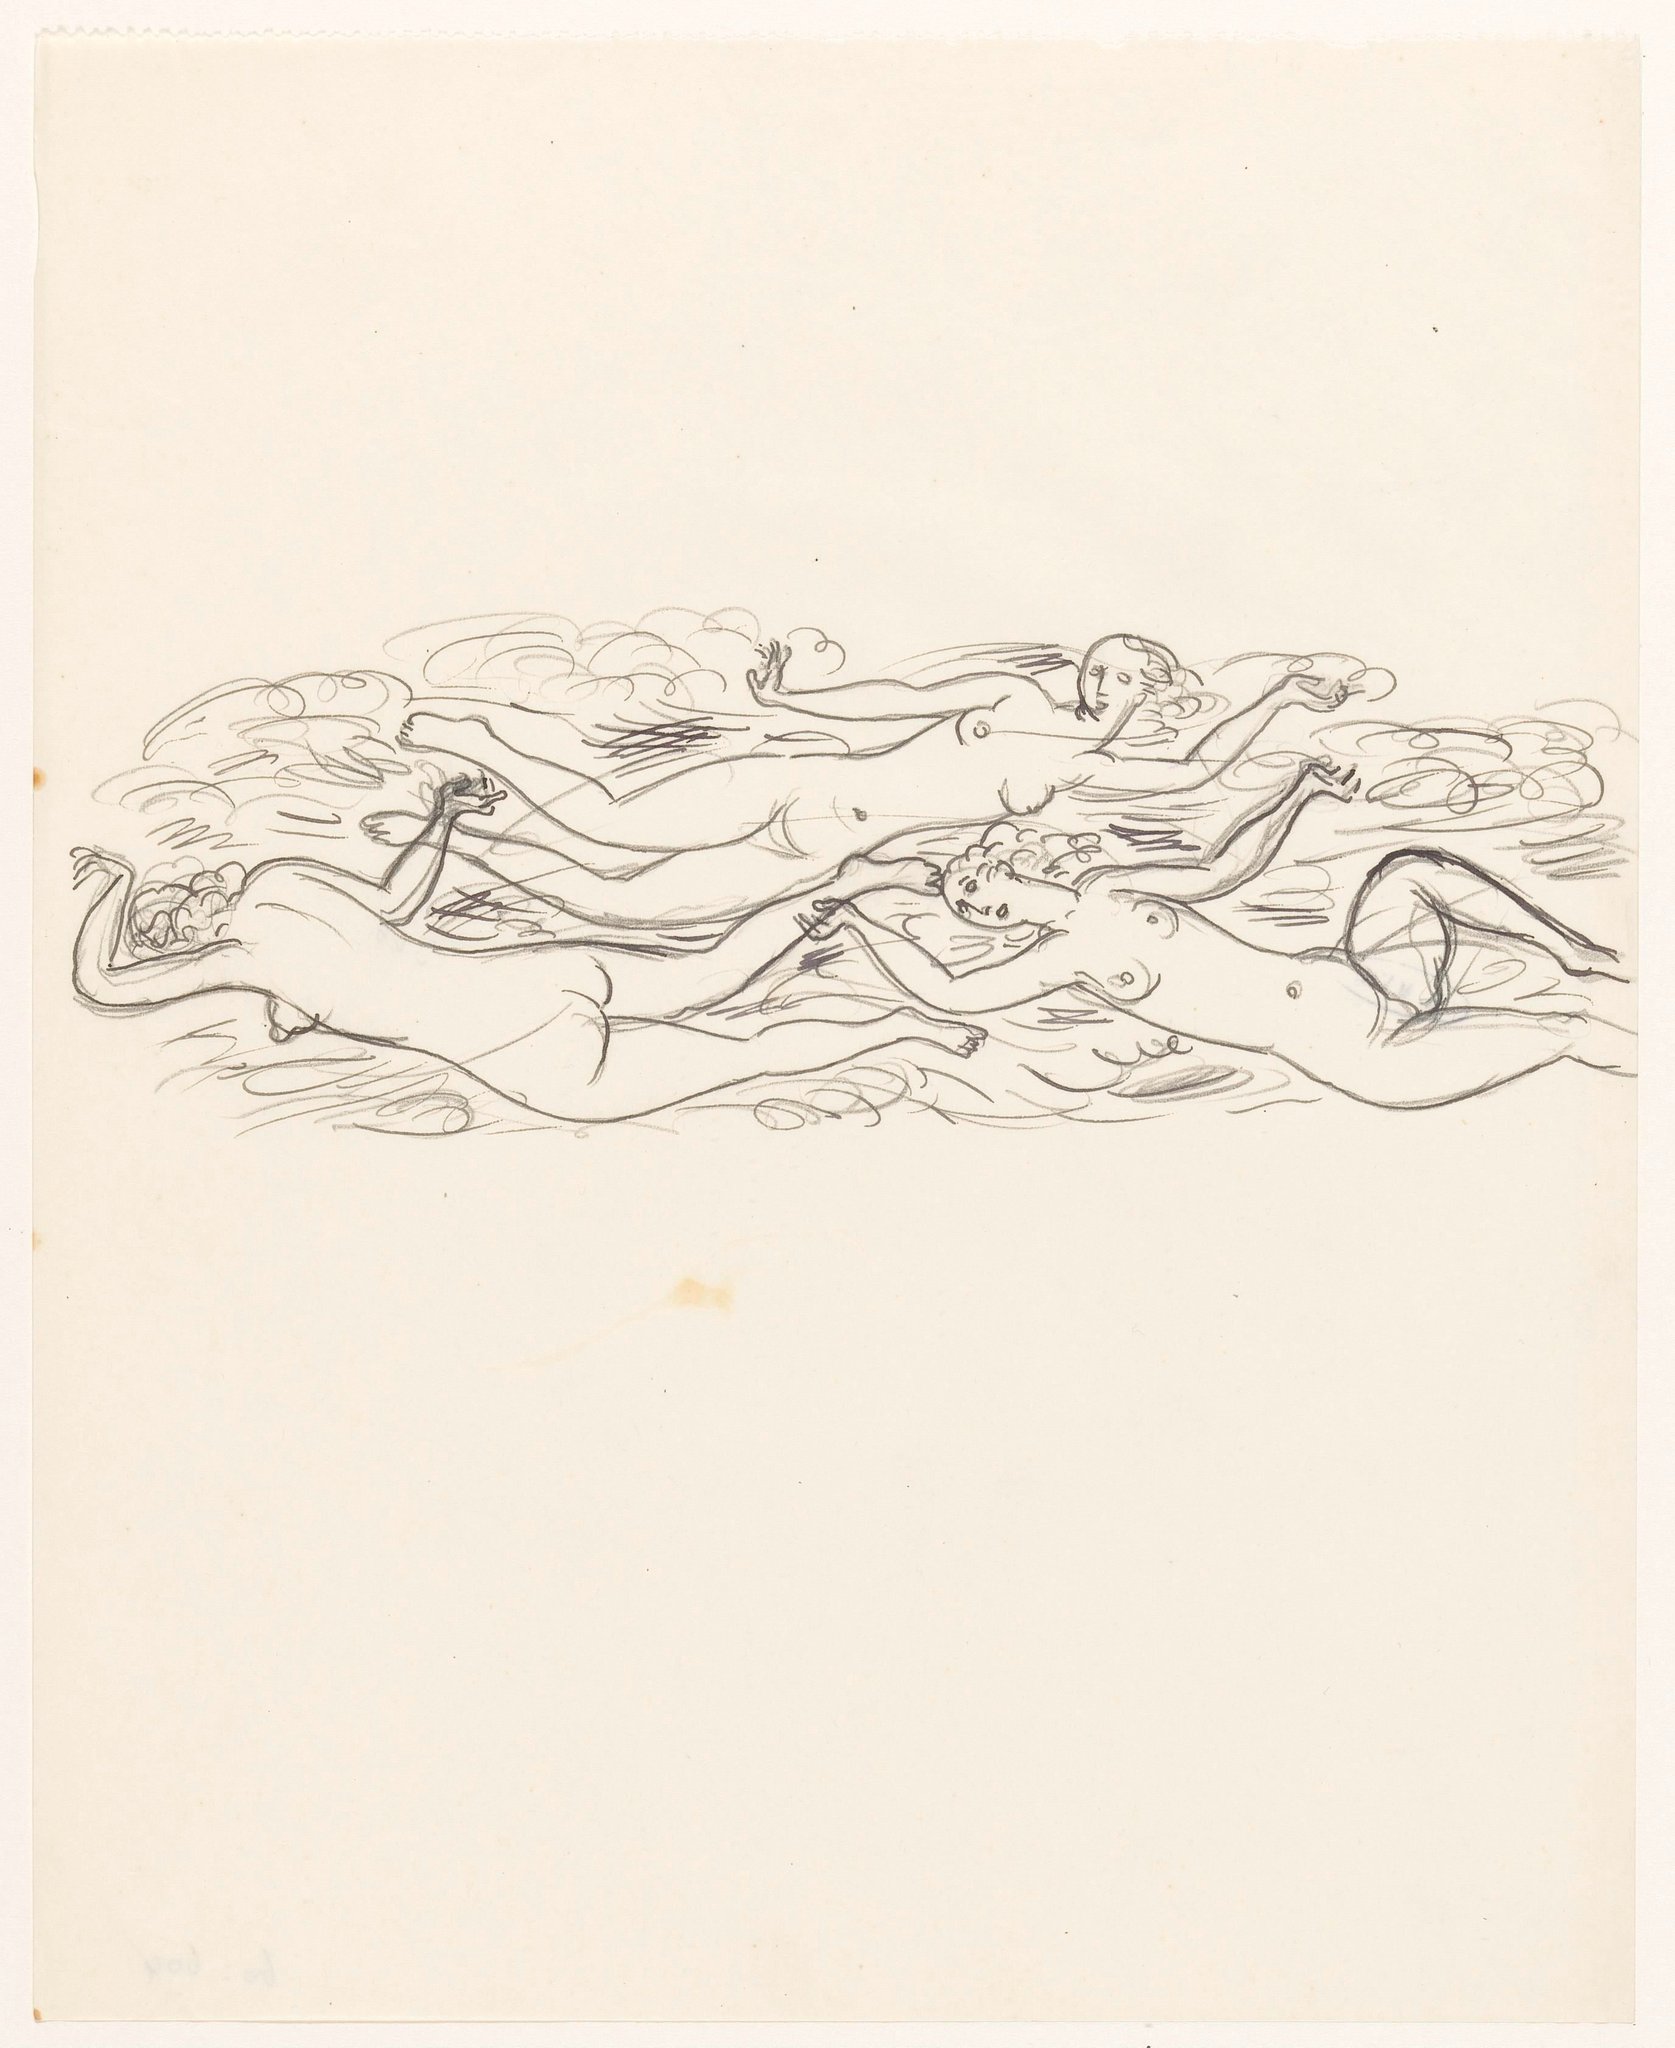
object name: drawing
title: Drie naakte vrouwen, zwemmend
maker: leo gestel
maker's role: draughtsman, print maker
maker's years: 1881-1941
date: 1891-1941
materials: ink, paper, pencil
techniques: pen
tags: swimming (movement in water) - aa - female human figure (+ nude human being)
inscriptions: collector's mark: Lugt 2228